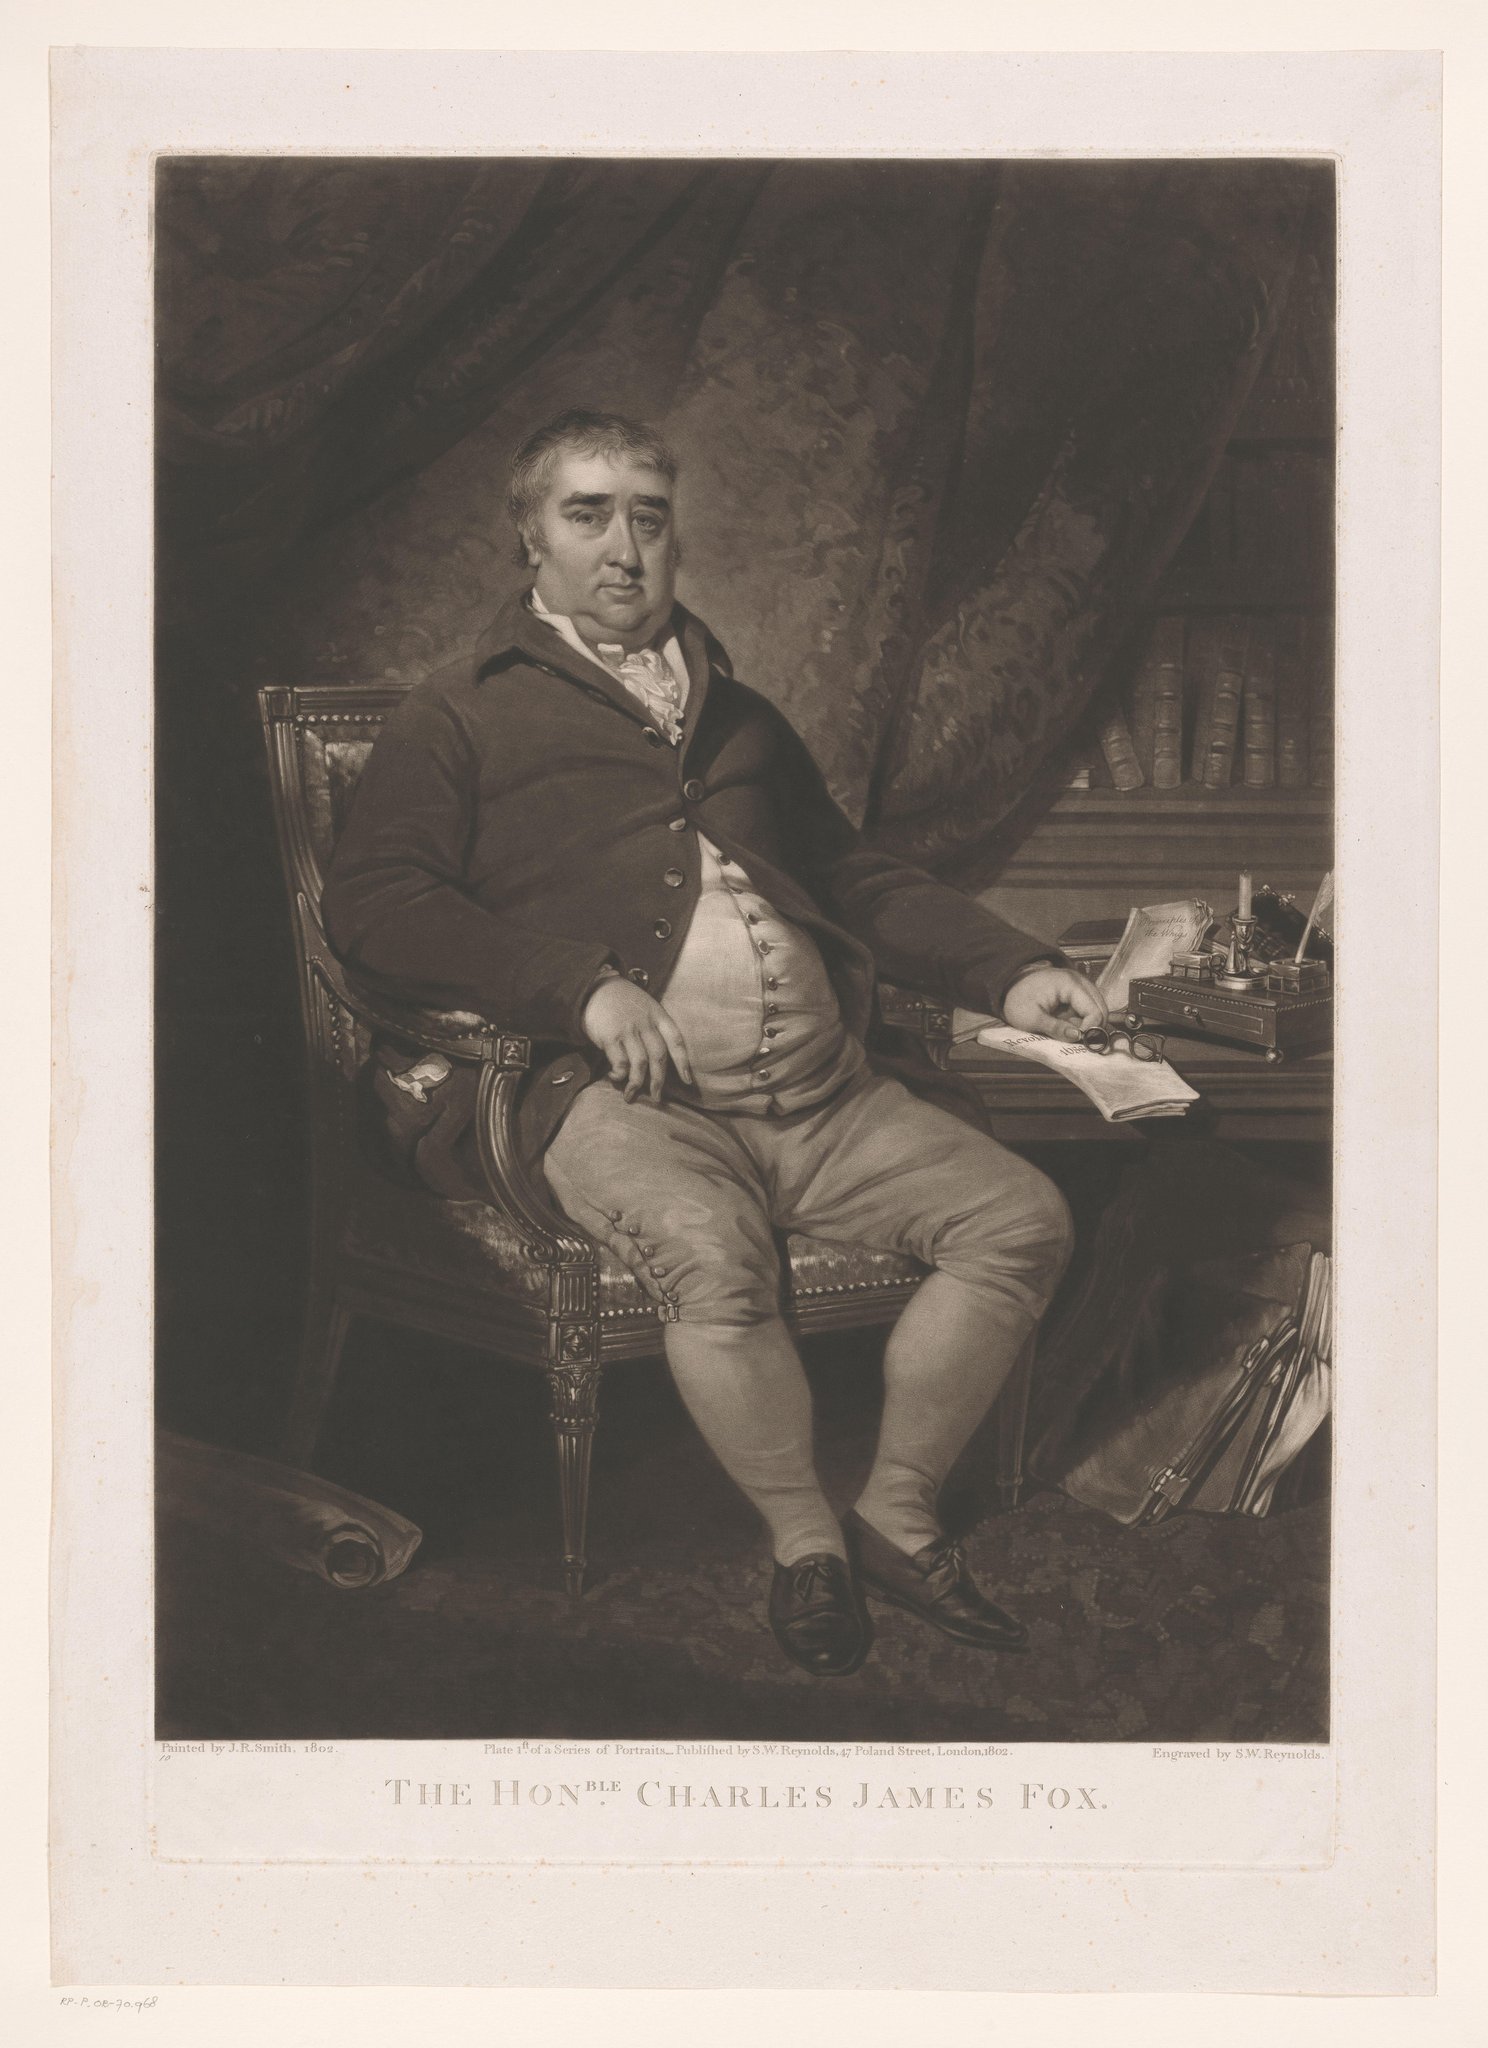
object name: print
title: Portret van Charles James Fox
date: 1802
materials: paper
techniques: engraving, etching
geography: london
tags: london, historical persons, politician, e.g. party leader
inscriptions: collector's mark: Lugt 12